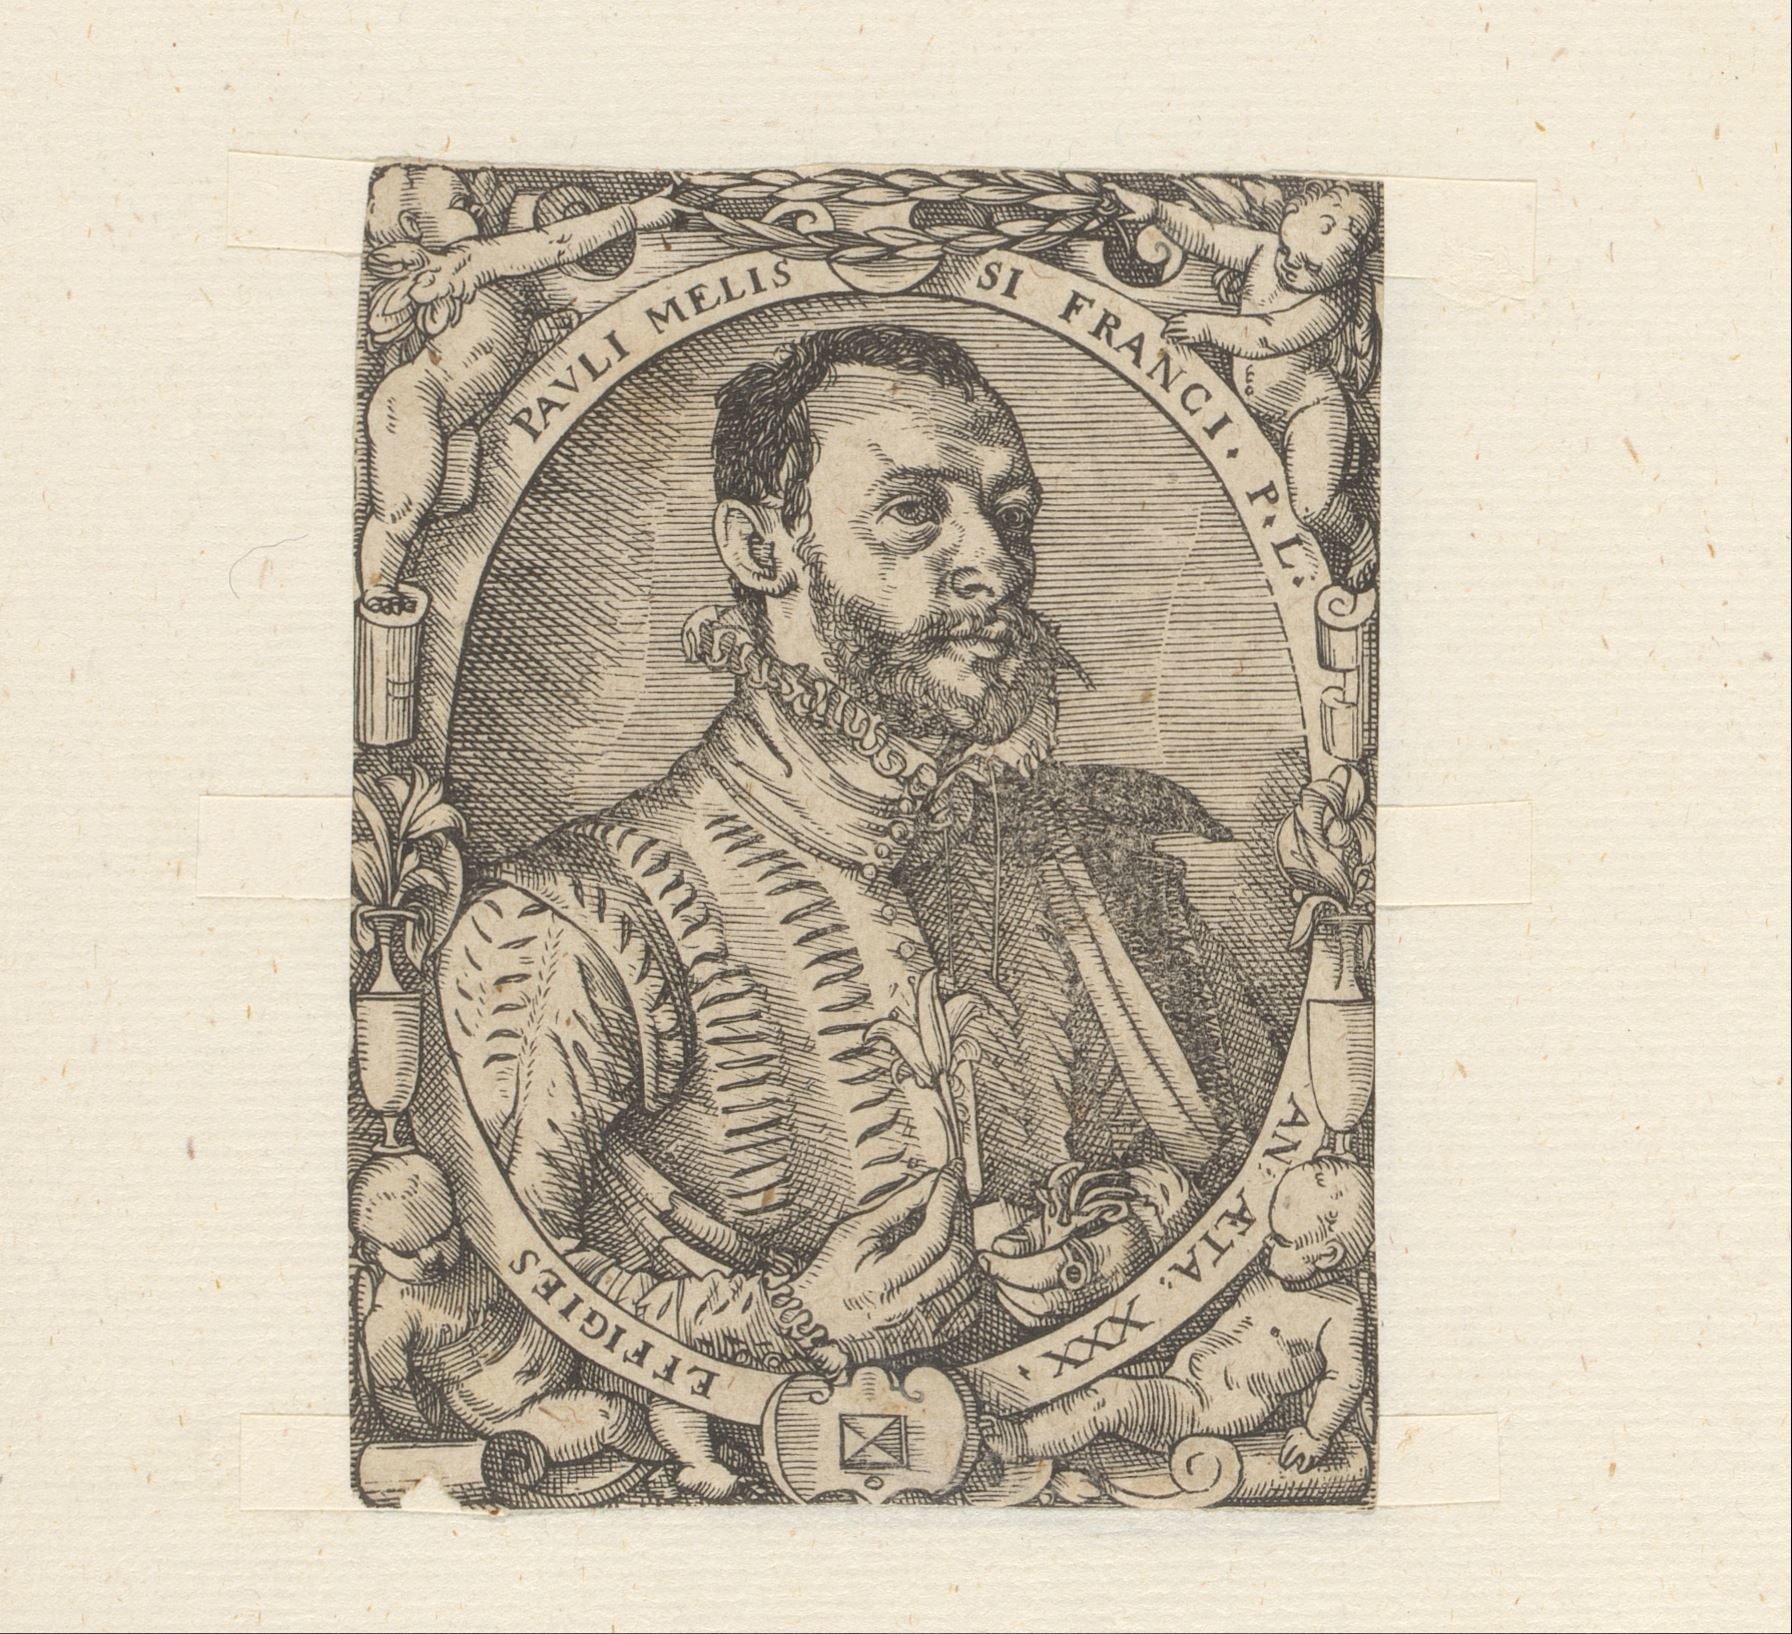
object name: book illustration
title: Portret van Paulus Melissus op 30-jarige leeftijd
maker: Anonymous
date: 1569-1575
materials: paper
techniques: woodcut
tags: paul schede, historical persons, portrait of a writer, portrait of composer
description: Prent is gebruikt in: Melissus, P. Reliquiae. Frankfurt: s.n., 1575.